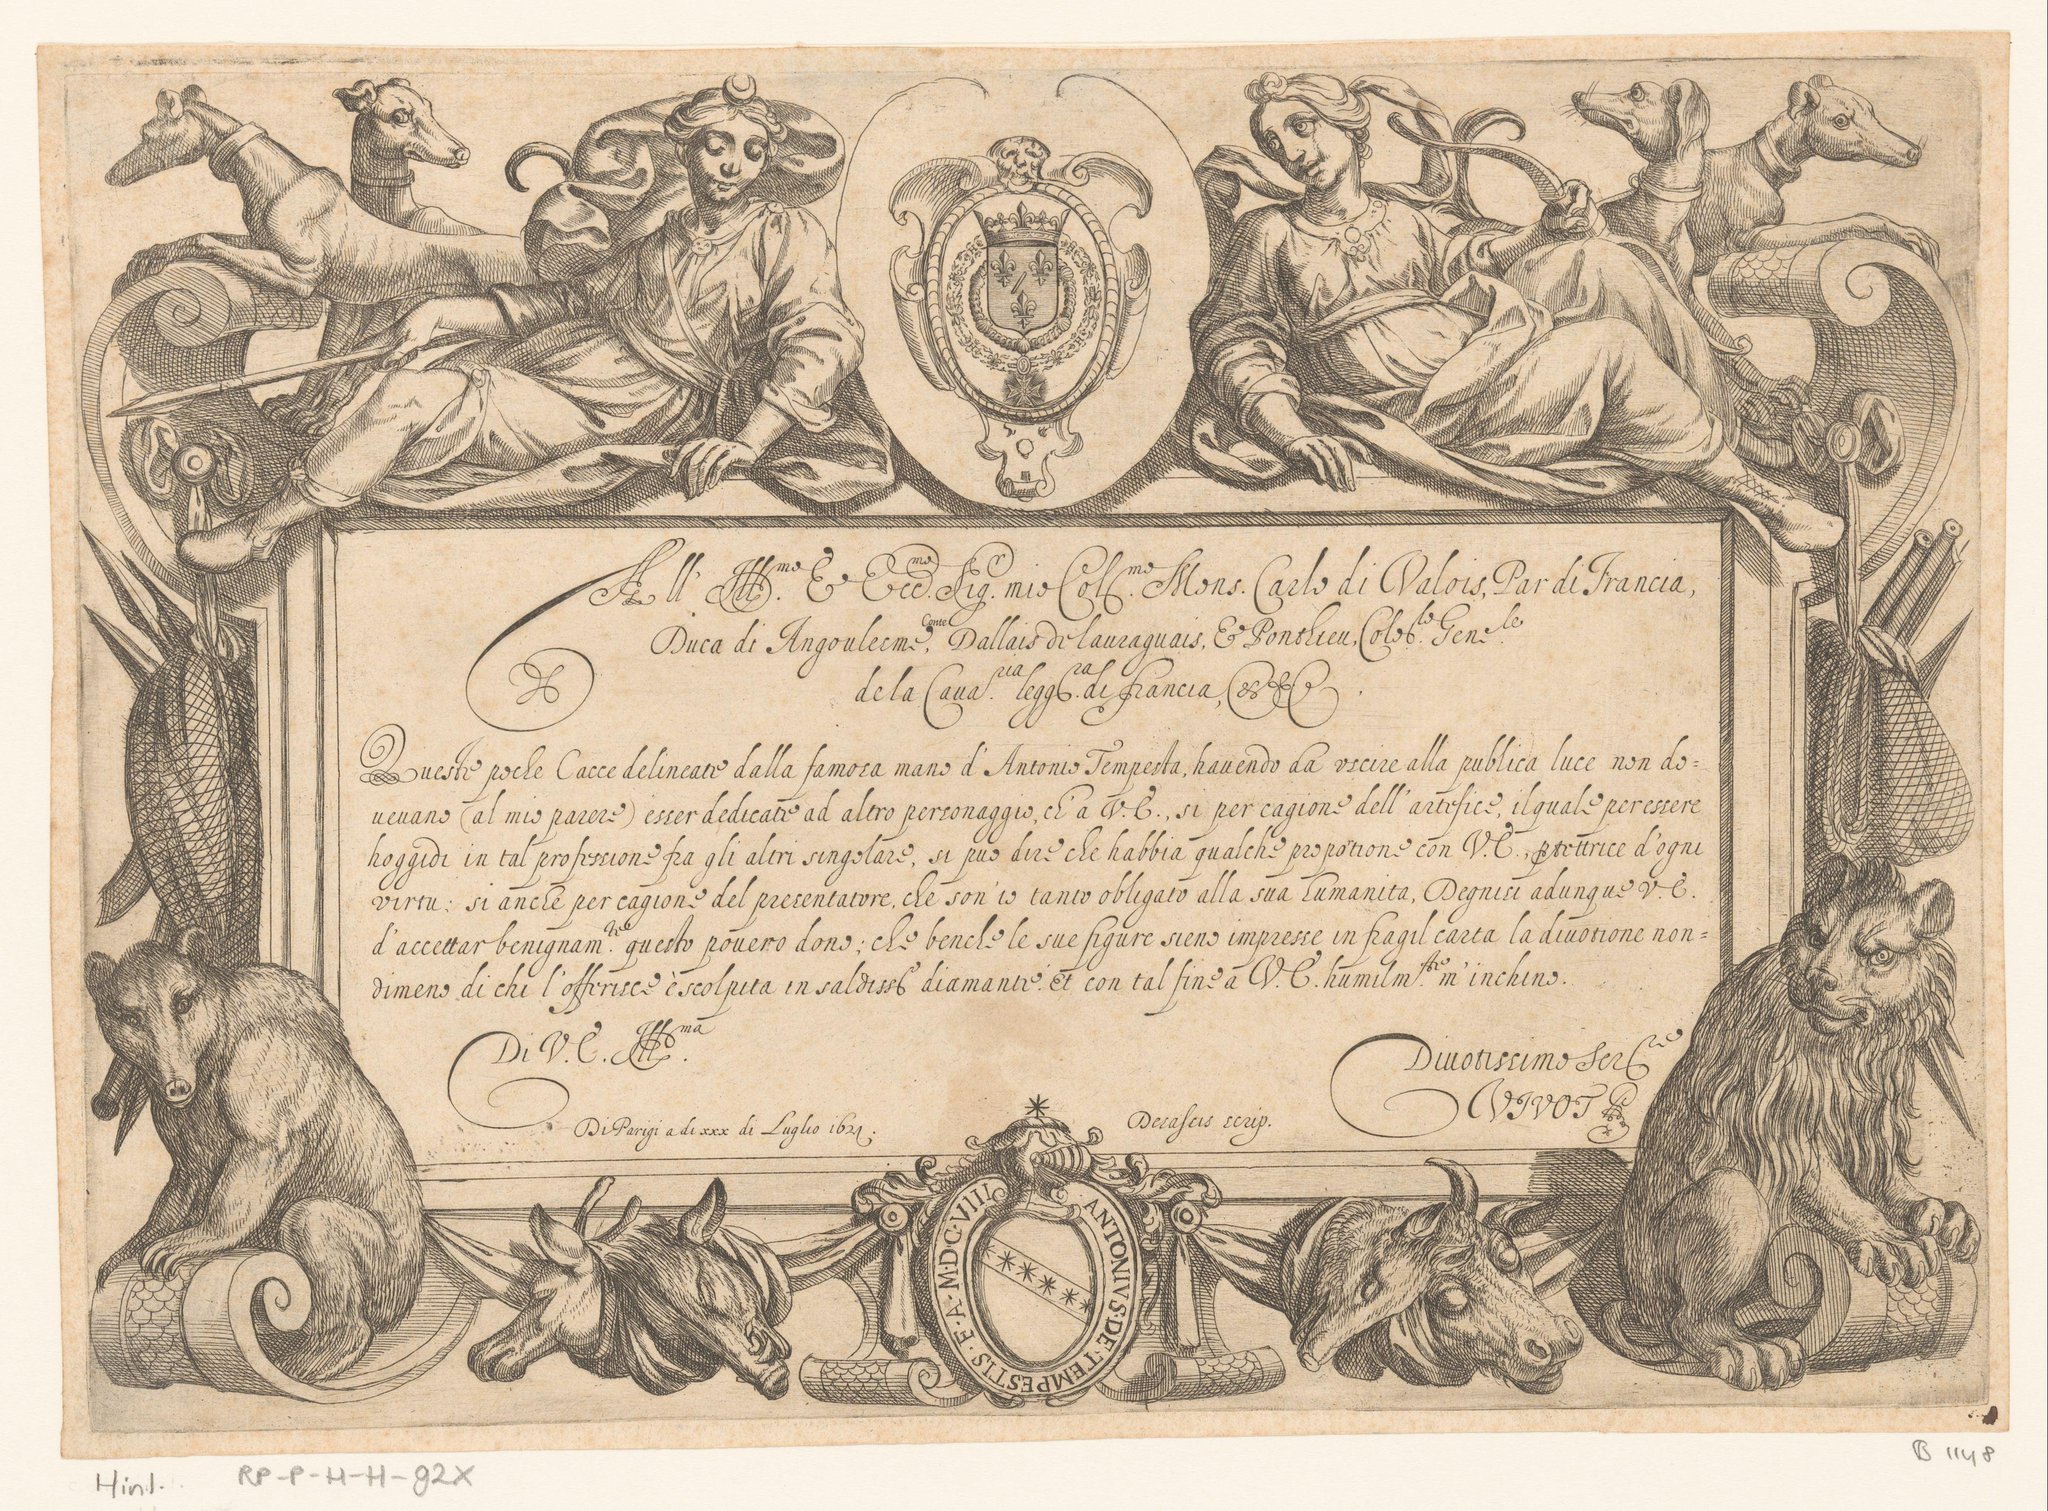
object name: print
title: Cartouche met opdracht, leeuw, beer, Diana, nimf en jachthonden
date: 1608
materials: paper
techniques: etching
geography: rome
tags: (story of) diana (artemis), hunting dogs, other companions, nymphs of diana, beasts of prey, predatory animals: bear, ornament ~ cartouche, beasts of prey, predatory animals: lion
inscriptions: number: ‘1’, collector's mark: ‘Hinloopen’, collector's mark: Lugt 11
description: Opdracht bij een reeks van acht prenten met jachtscènes.